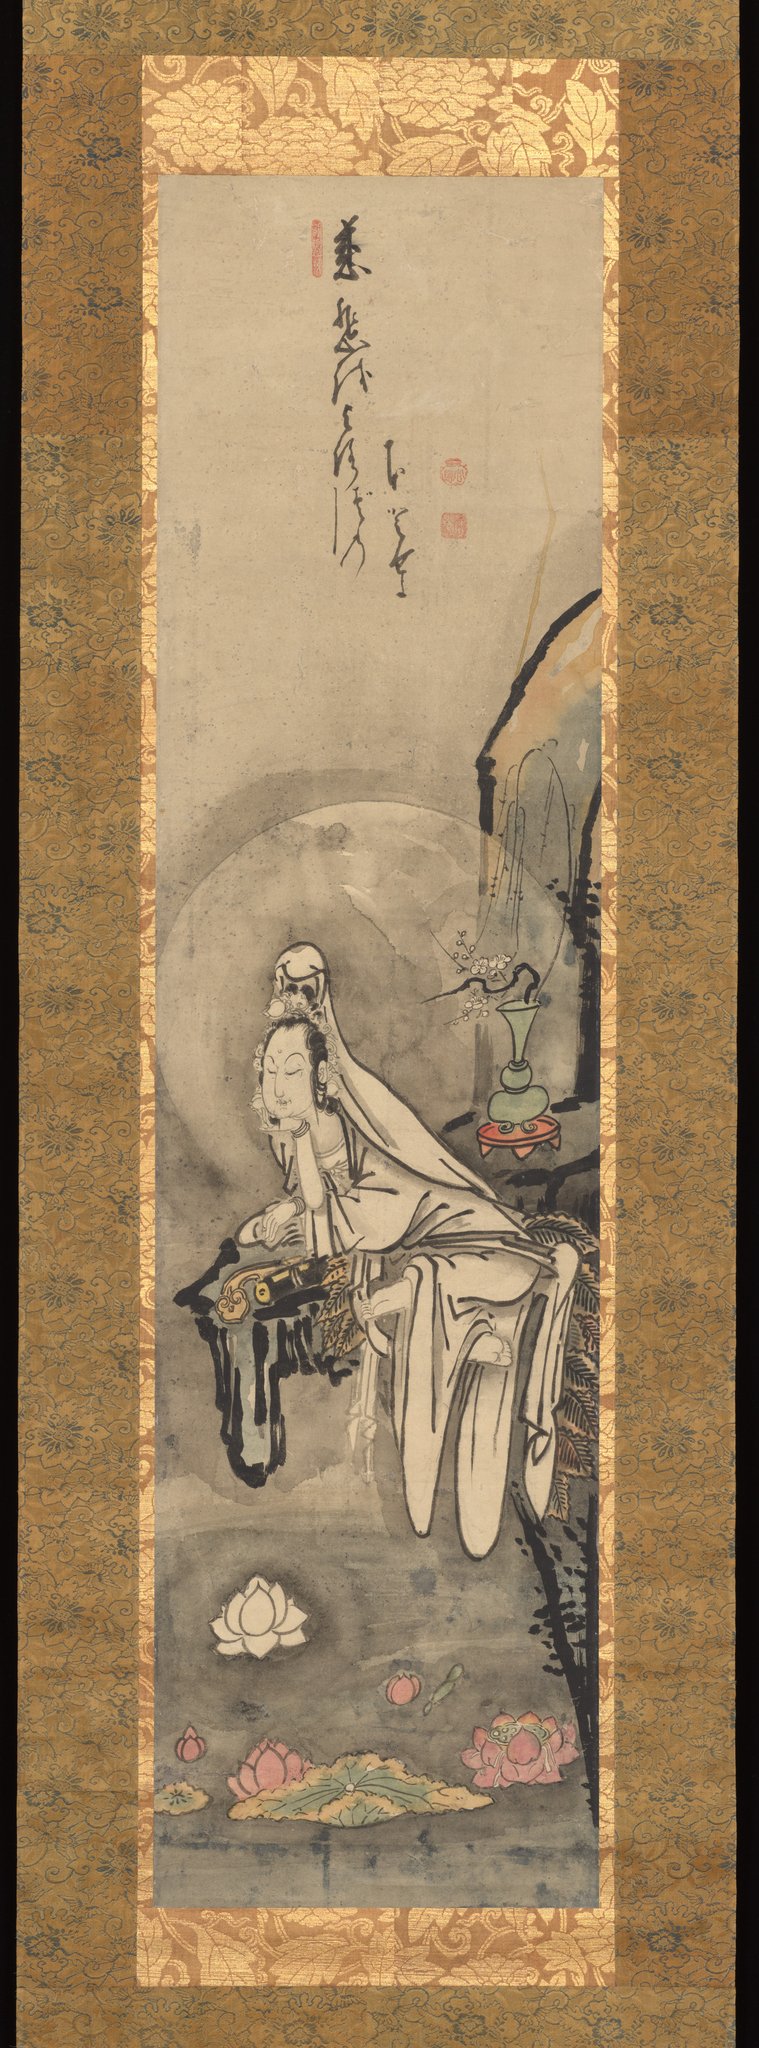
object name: hanging scroll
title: Kannon by a Lotus Pond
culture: japanese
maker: hakuin ekaku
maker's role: artist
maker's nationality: japanese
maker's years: 1686-1769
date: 1750-1759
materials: ink, paper